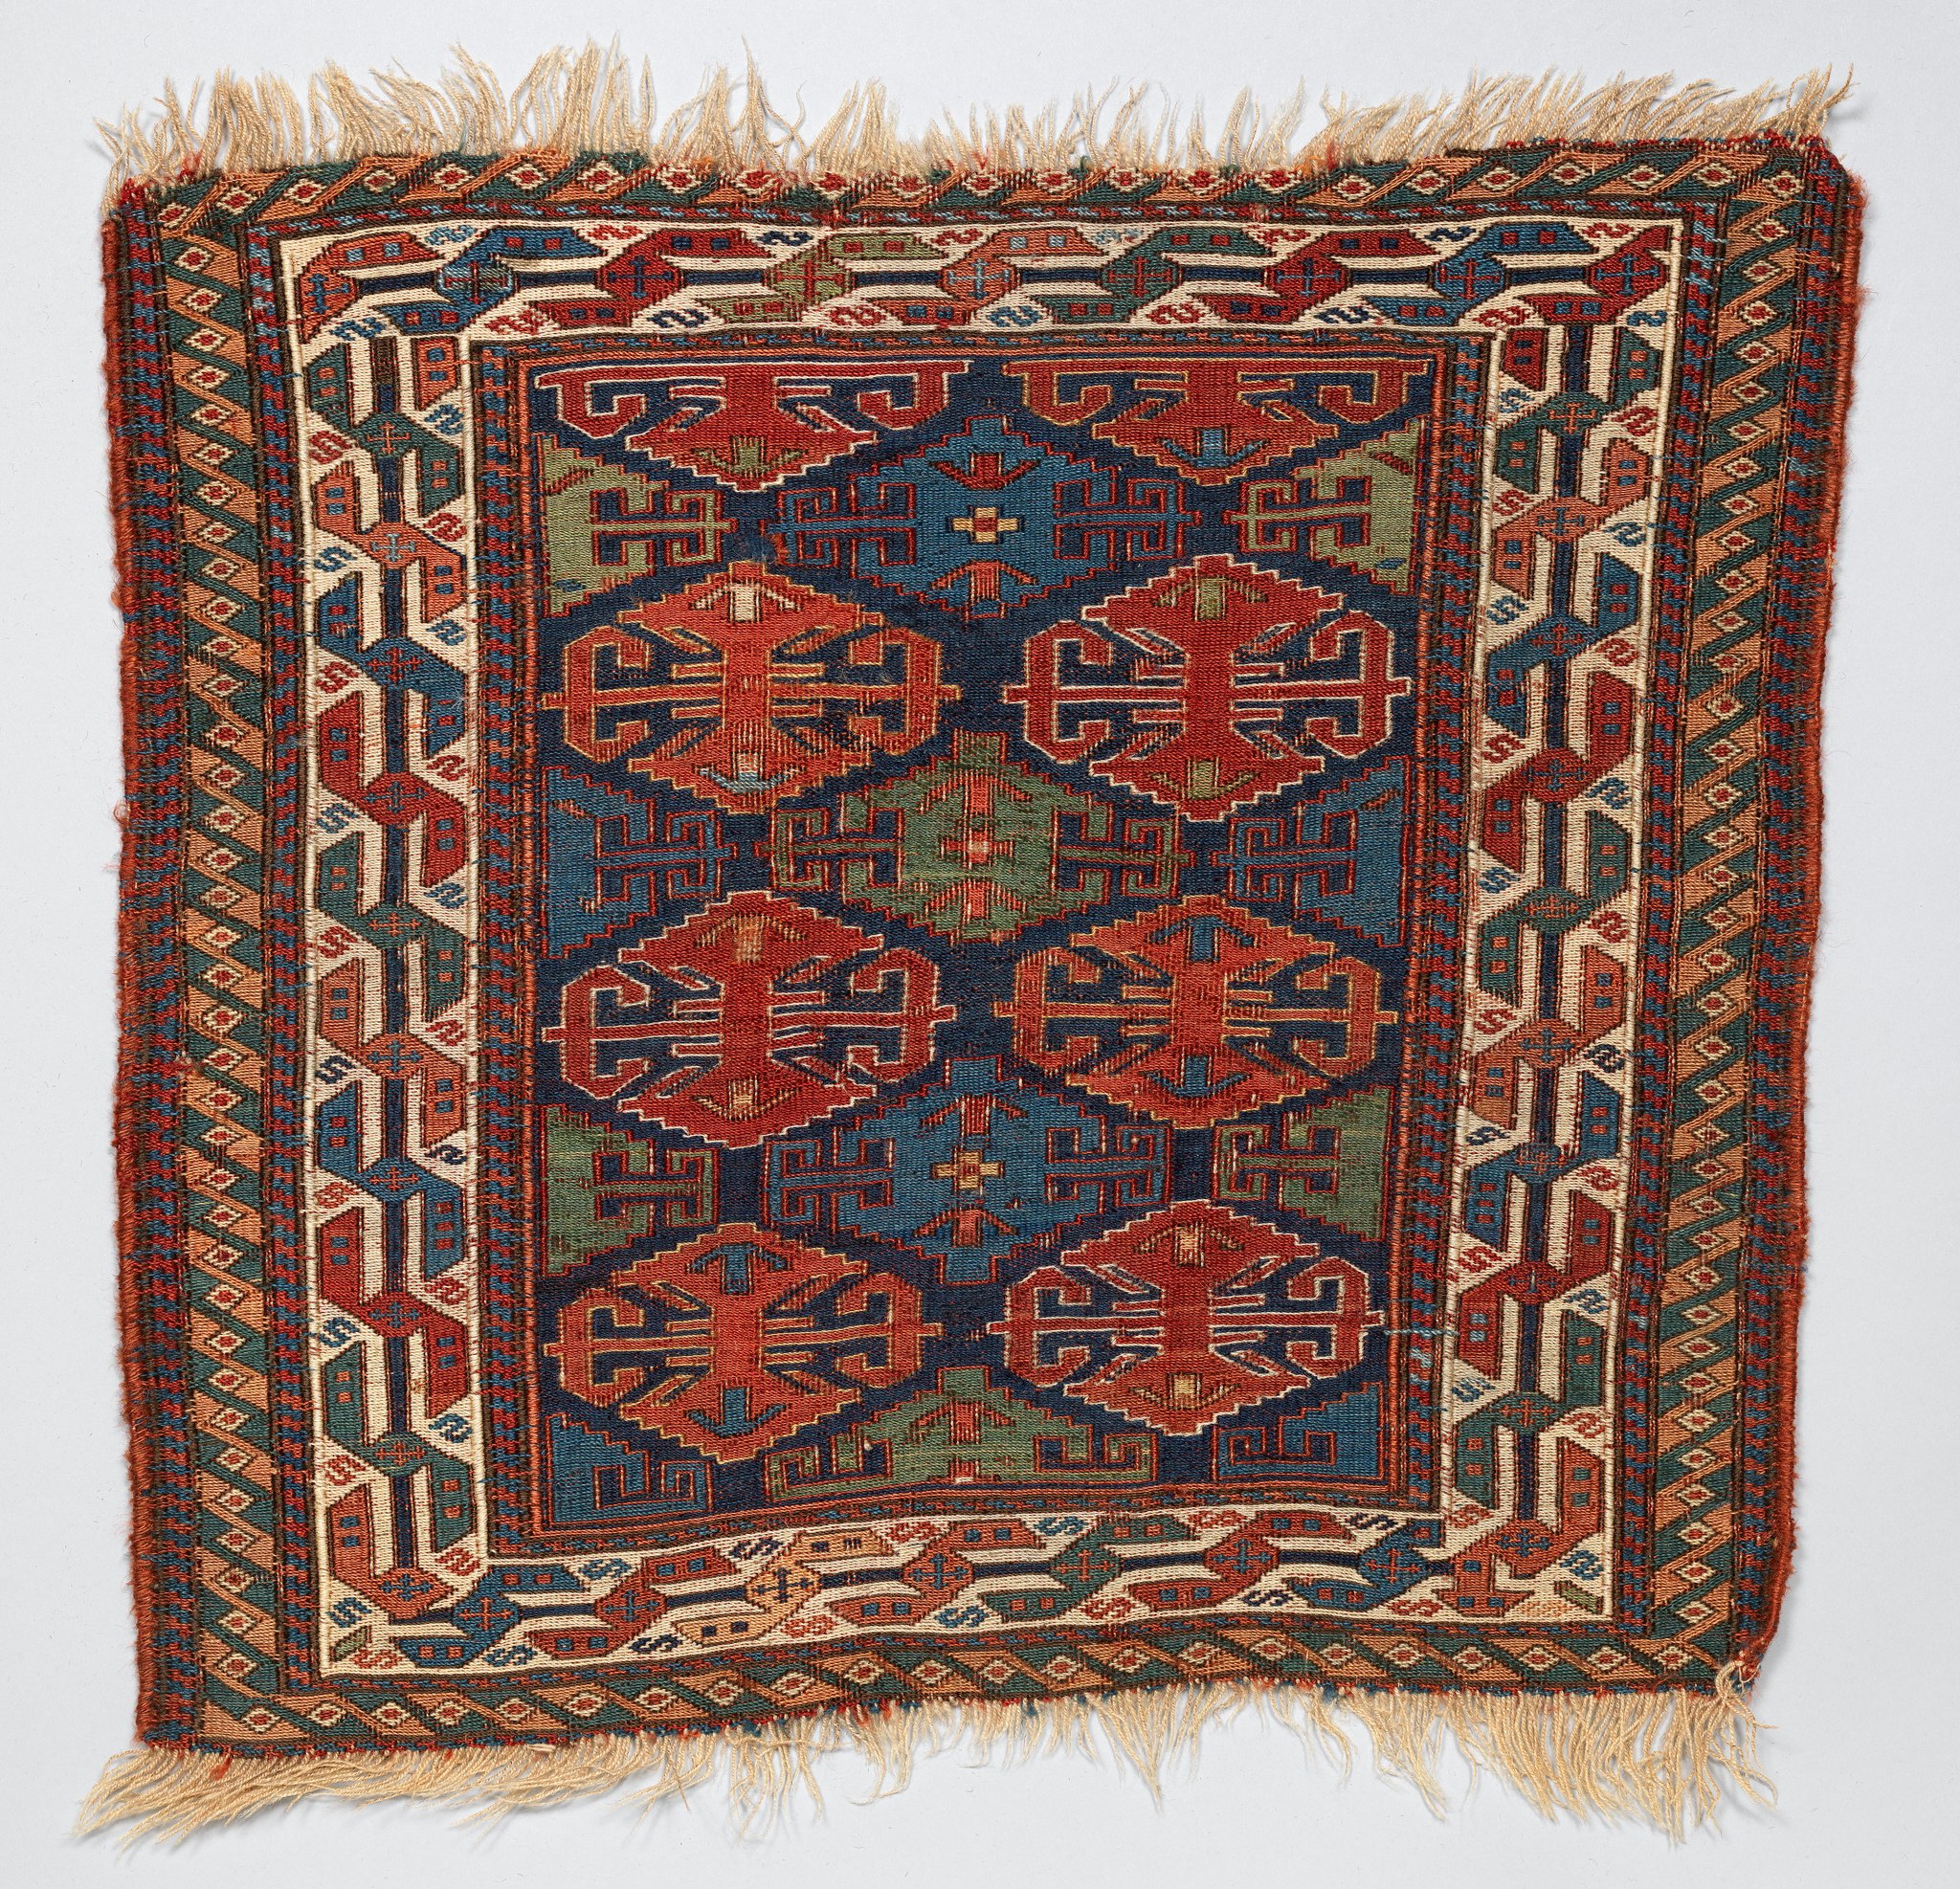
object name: saddle bag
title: Face from Half of Double Saddle Bag (Khorjin)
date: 1801-1900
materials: wool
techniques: brocade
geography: northwestern iran